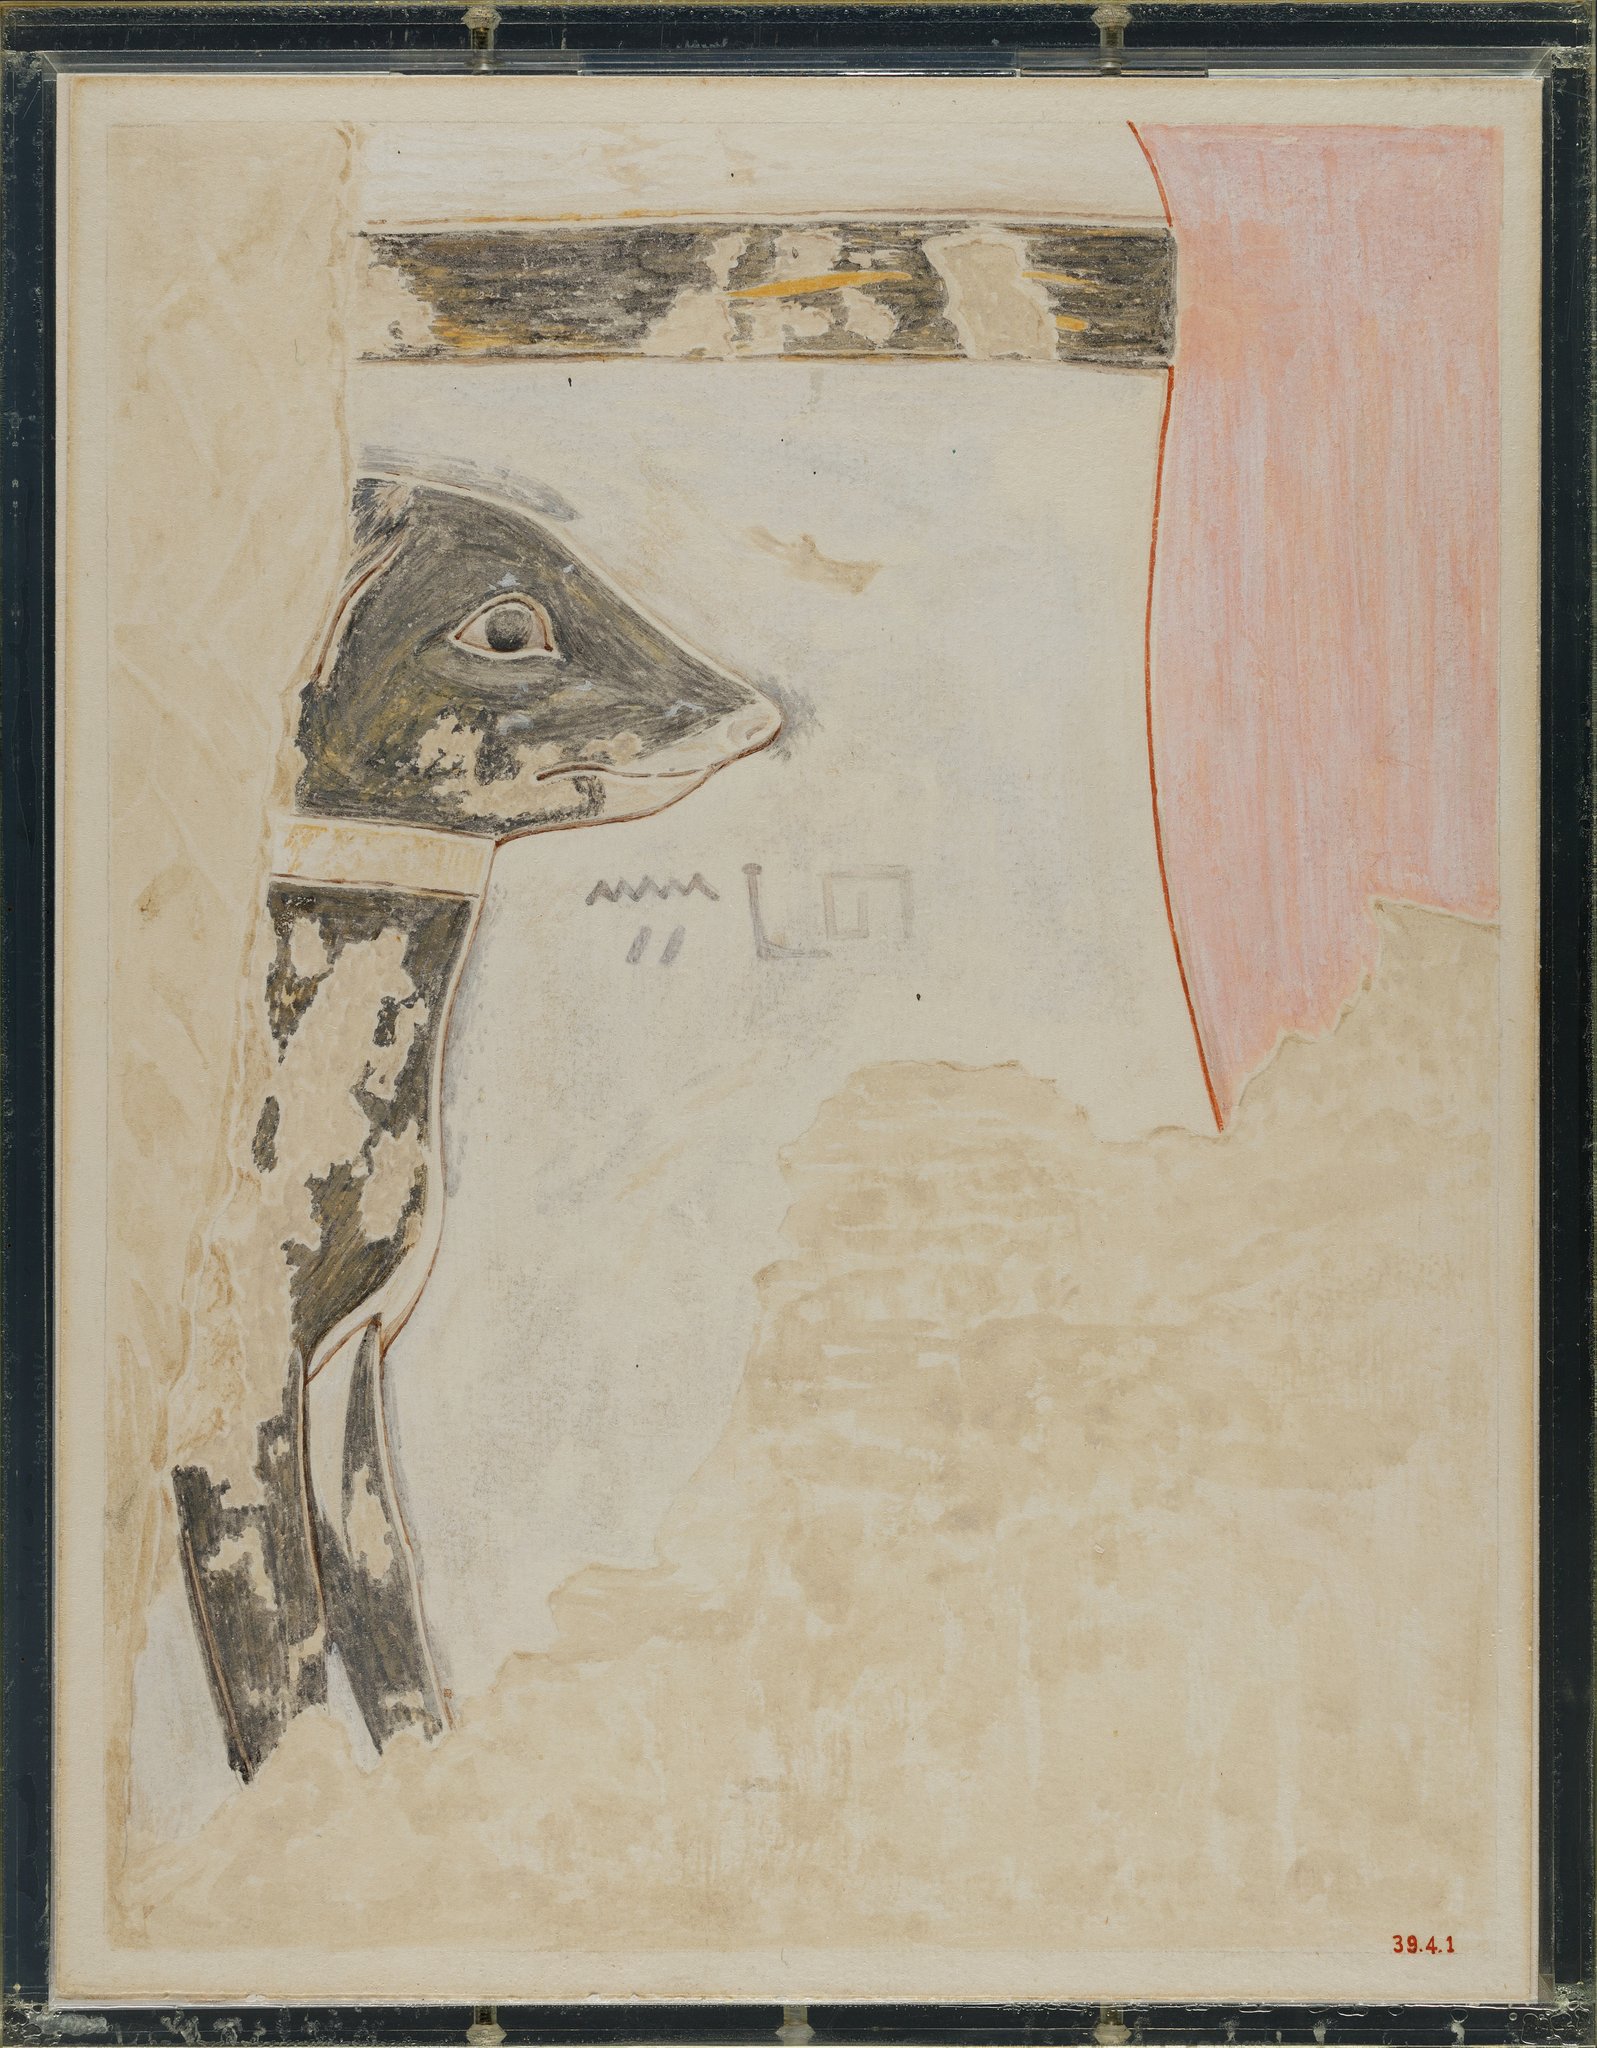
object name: facsimile, dog named ebony, duauneheh tt 125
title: Dog Named Ebony Under Owner's Chair, Tomb of Duaerneheh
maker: nina de garis davies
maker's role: artist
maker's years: 1881-1965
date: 1479-1458 BCE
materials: paper, paint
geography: egypt